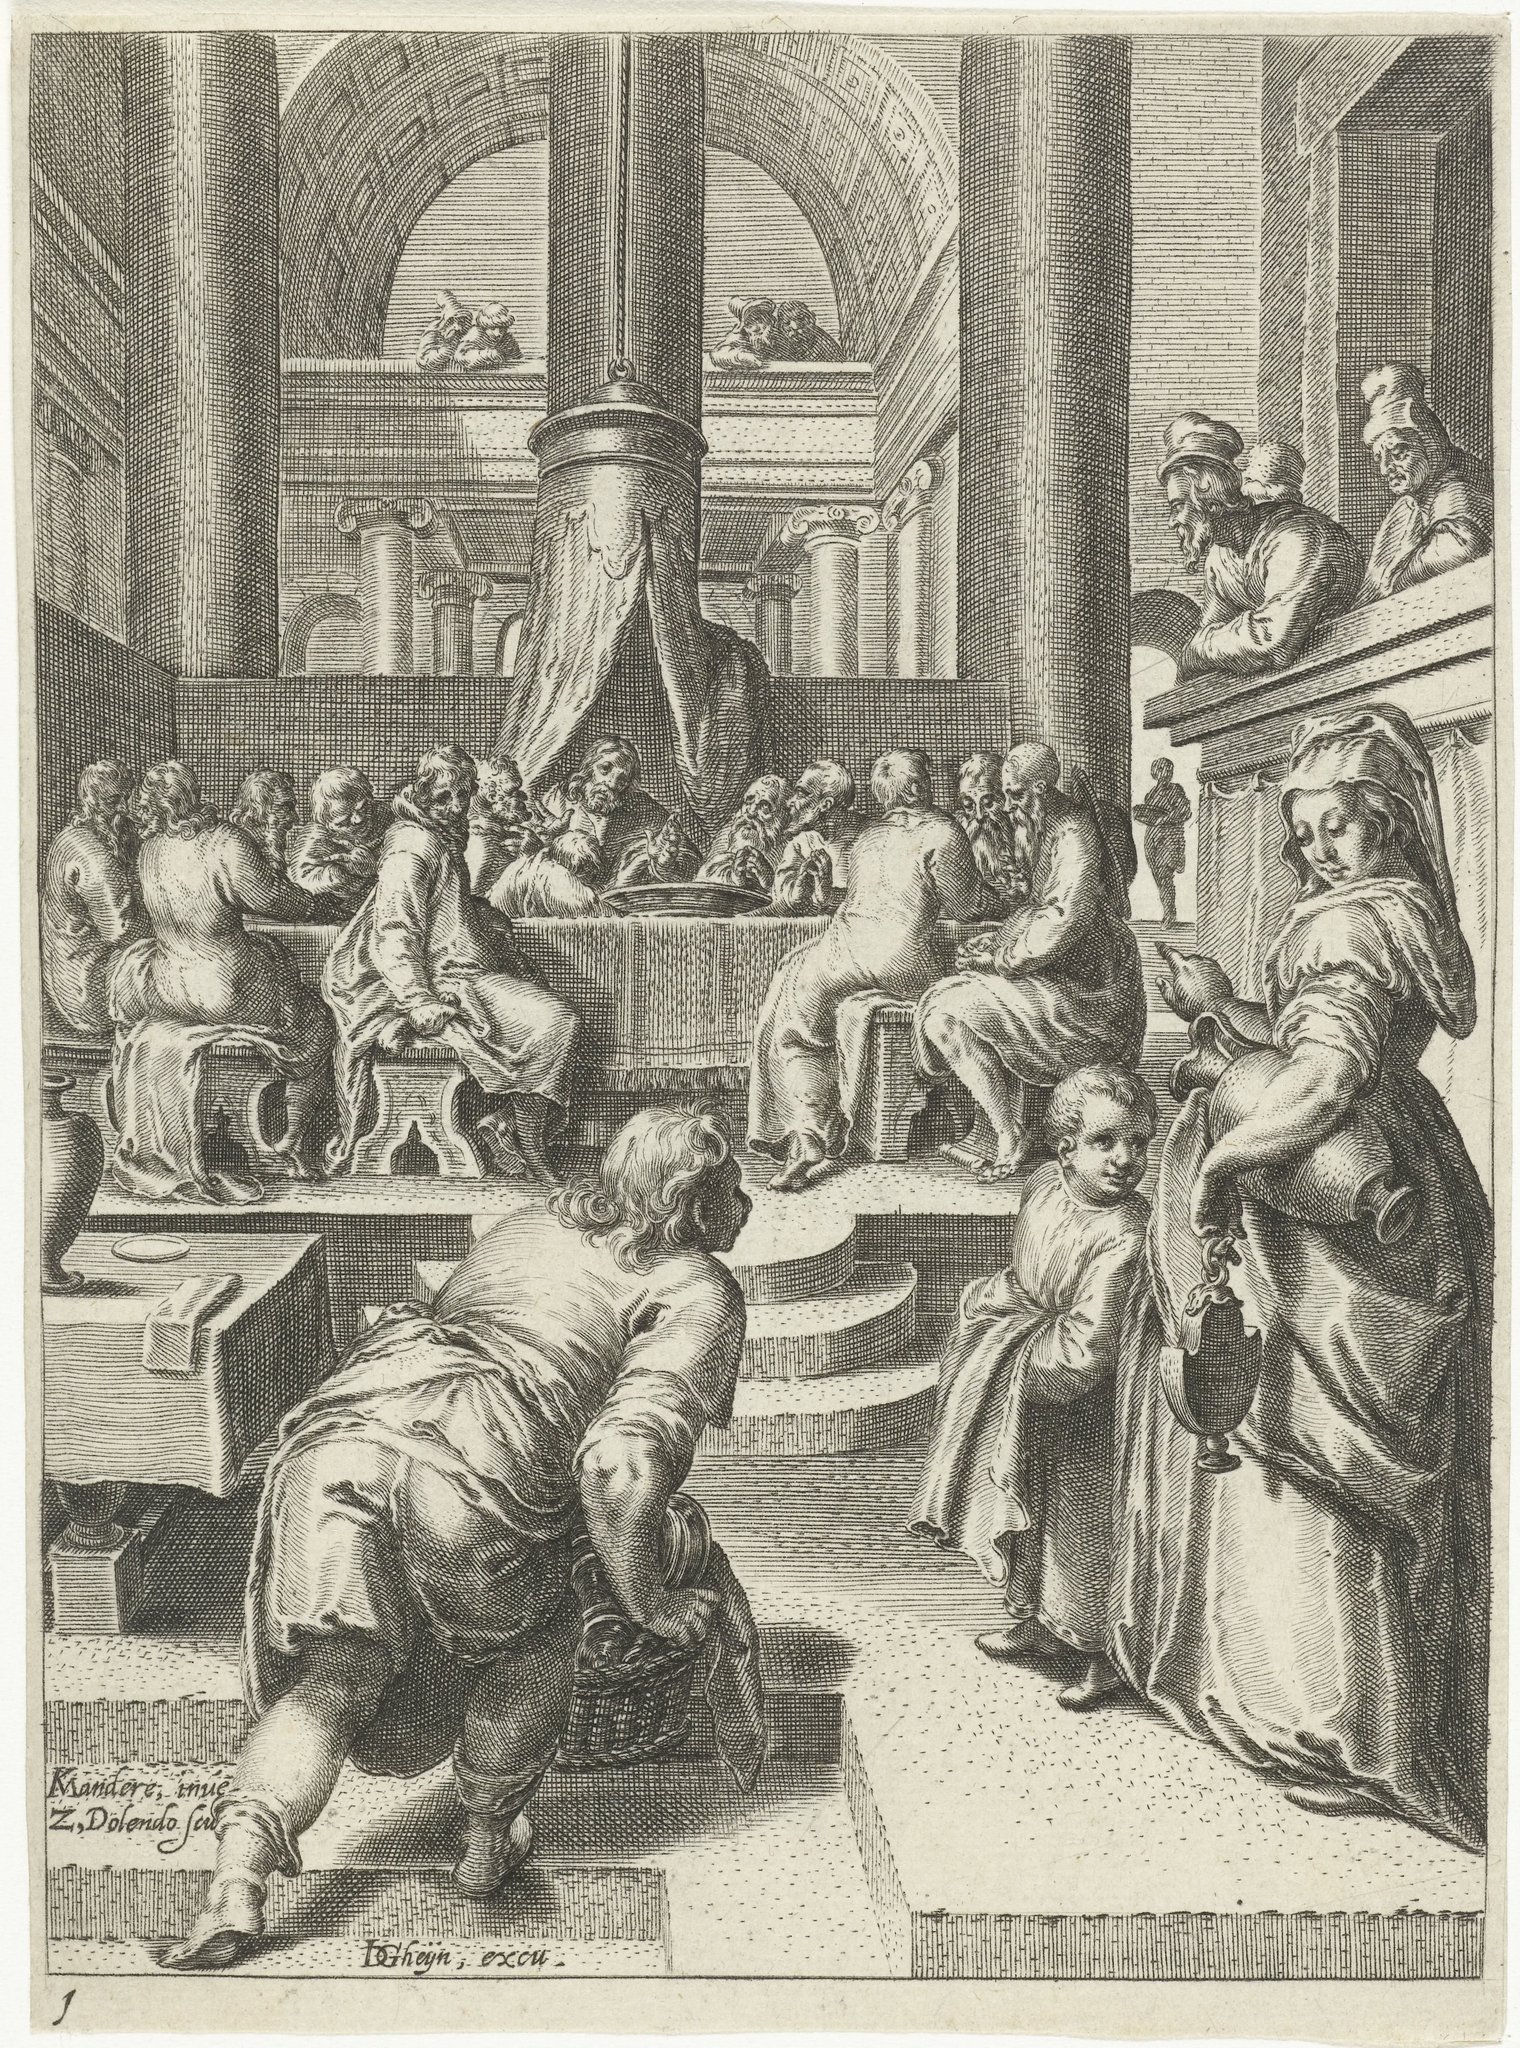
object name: print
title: Laatste avondmaal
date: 1596-1598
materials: paper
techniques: engraving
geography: leiden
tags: last supper (in general) (matthew 26:21-35; mark 14:18-31; luke 22:3, 22:15-23; john 13:21-38)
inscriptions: collector's mark: Lugt 2228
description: Christus zit met zijn discipelen rond een tafel in een grote, sacrale ruimte. Op de voorgrond brengen twee bedienden brood en wijn. Een man tilt een mand met brood op en een vrouw met een jongen draagt kruiken met wijn. Prent uit een serie van 13 prenten en een titelprent vervaardigt door Z. Dolendo en J. de Gheyn II.